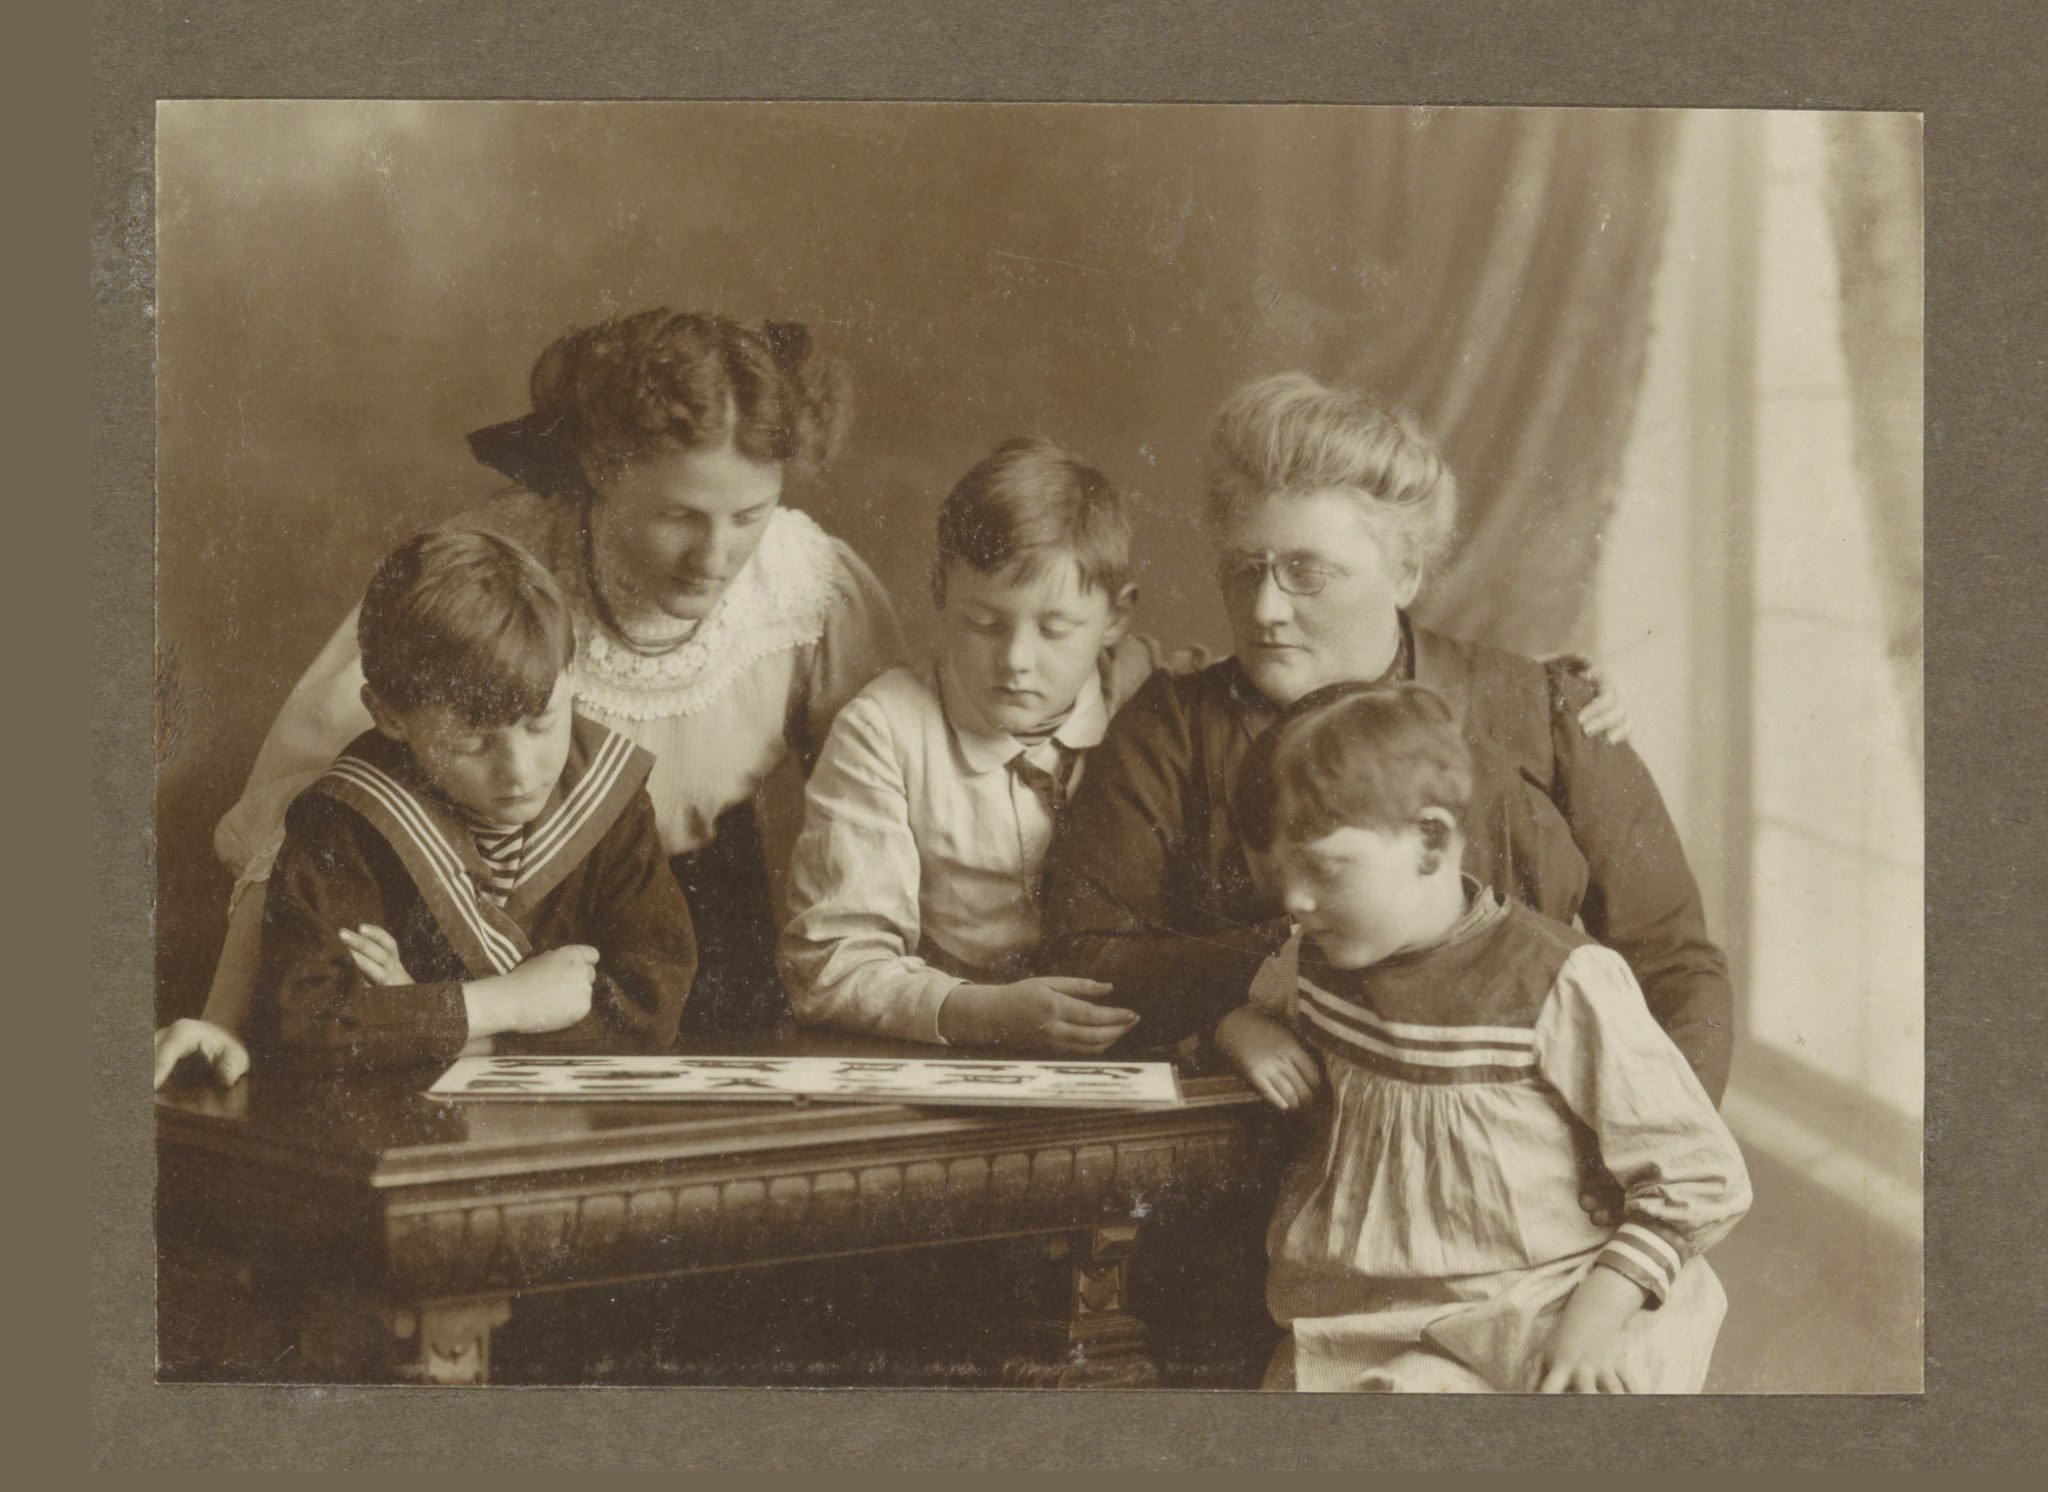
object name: photograph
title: Groepsportret van G. Vermeulen-Luitjes (met bril) en de kinderen Vermeulen, een plaatjesboek bekijkend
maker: cornelis johannes lodewicus vermeulen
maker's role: fotograaf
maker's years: 1861-1936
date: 1900-1920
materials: paper, photographic support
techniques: gelatin silver print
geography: the hague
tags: reading, family group, especially parents with their child(ren), reading a picture book, the hague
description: Onderdeel van Fotoalbum met opnames van het gezin en het huis van fotograaf C.J.L. Vermeulen in Den Haag.